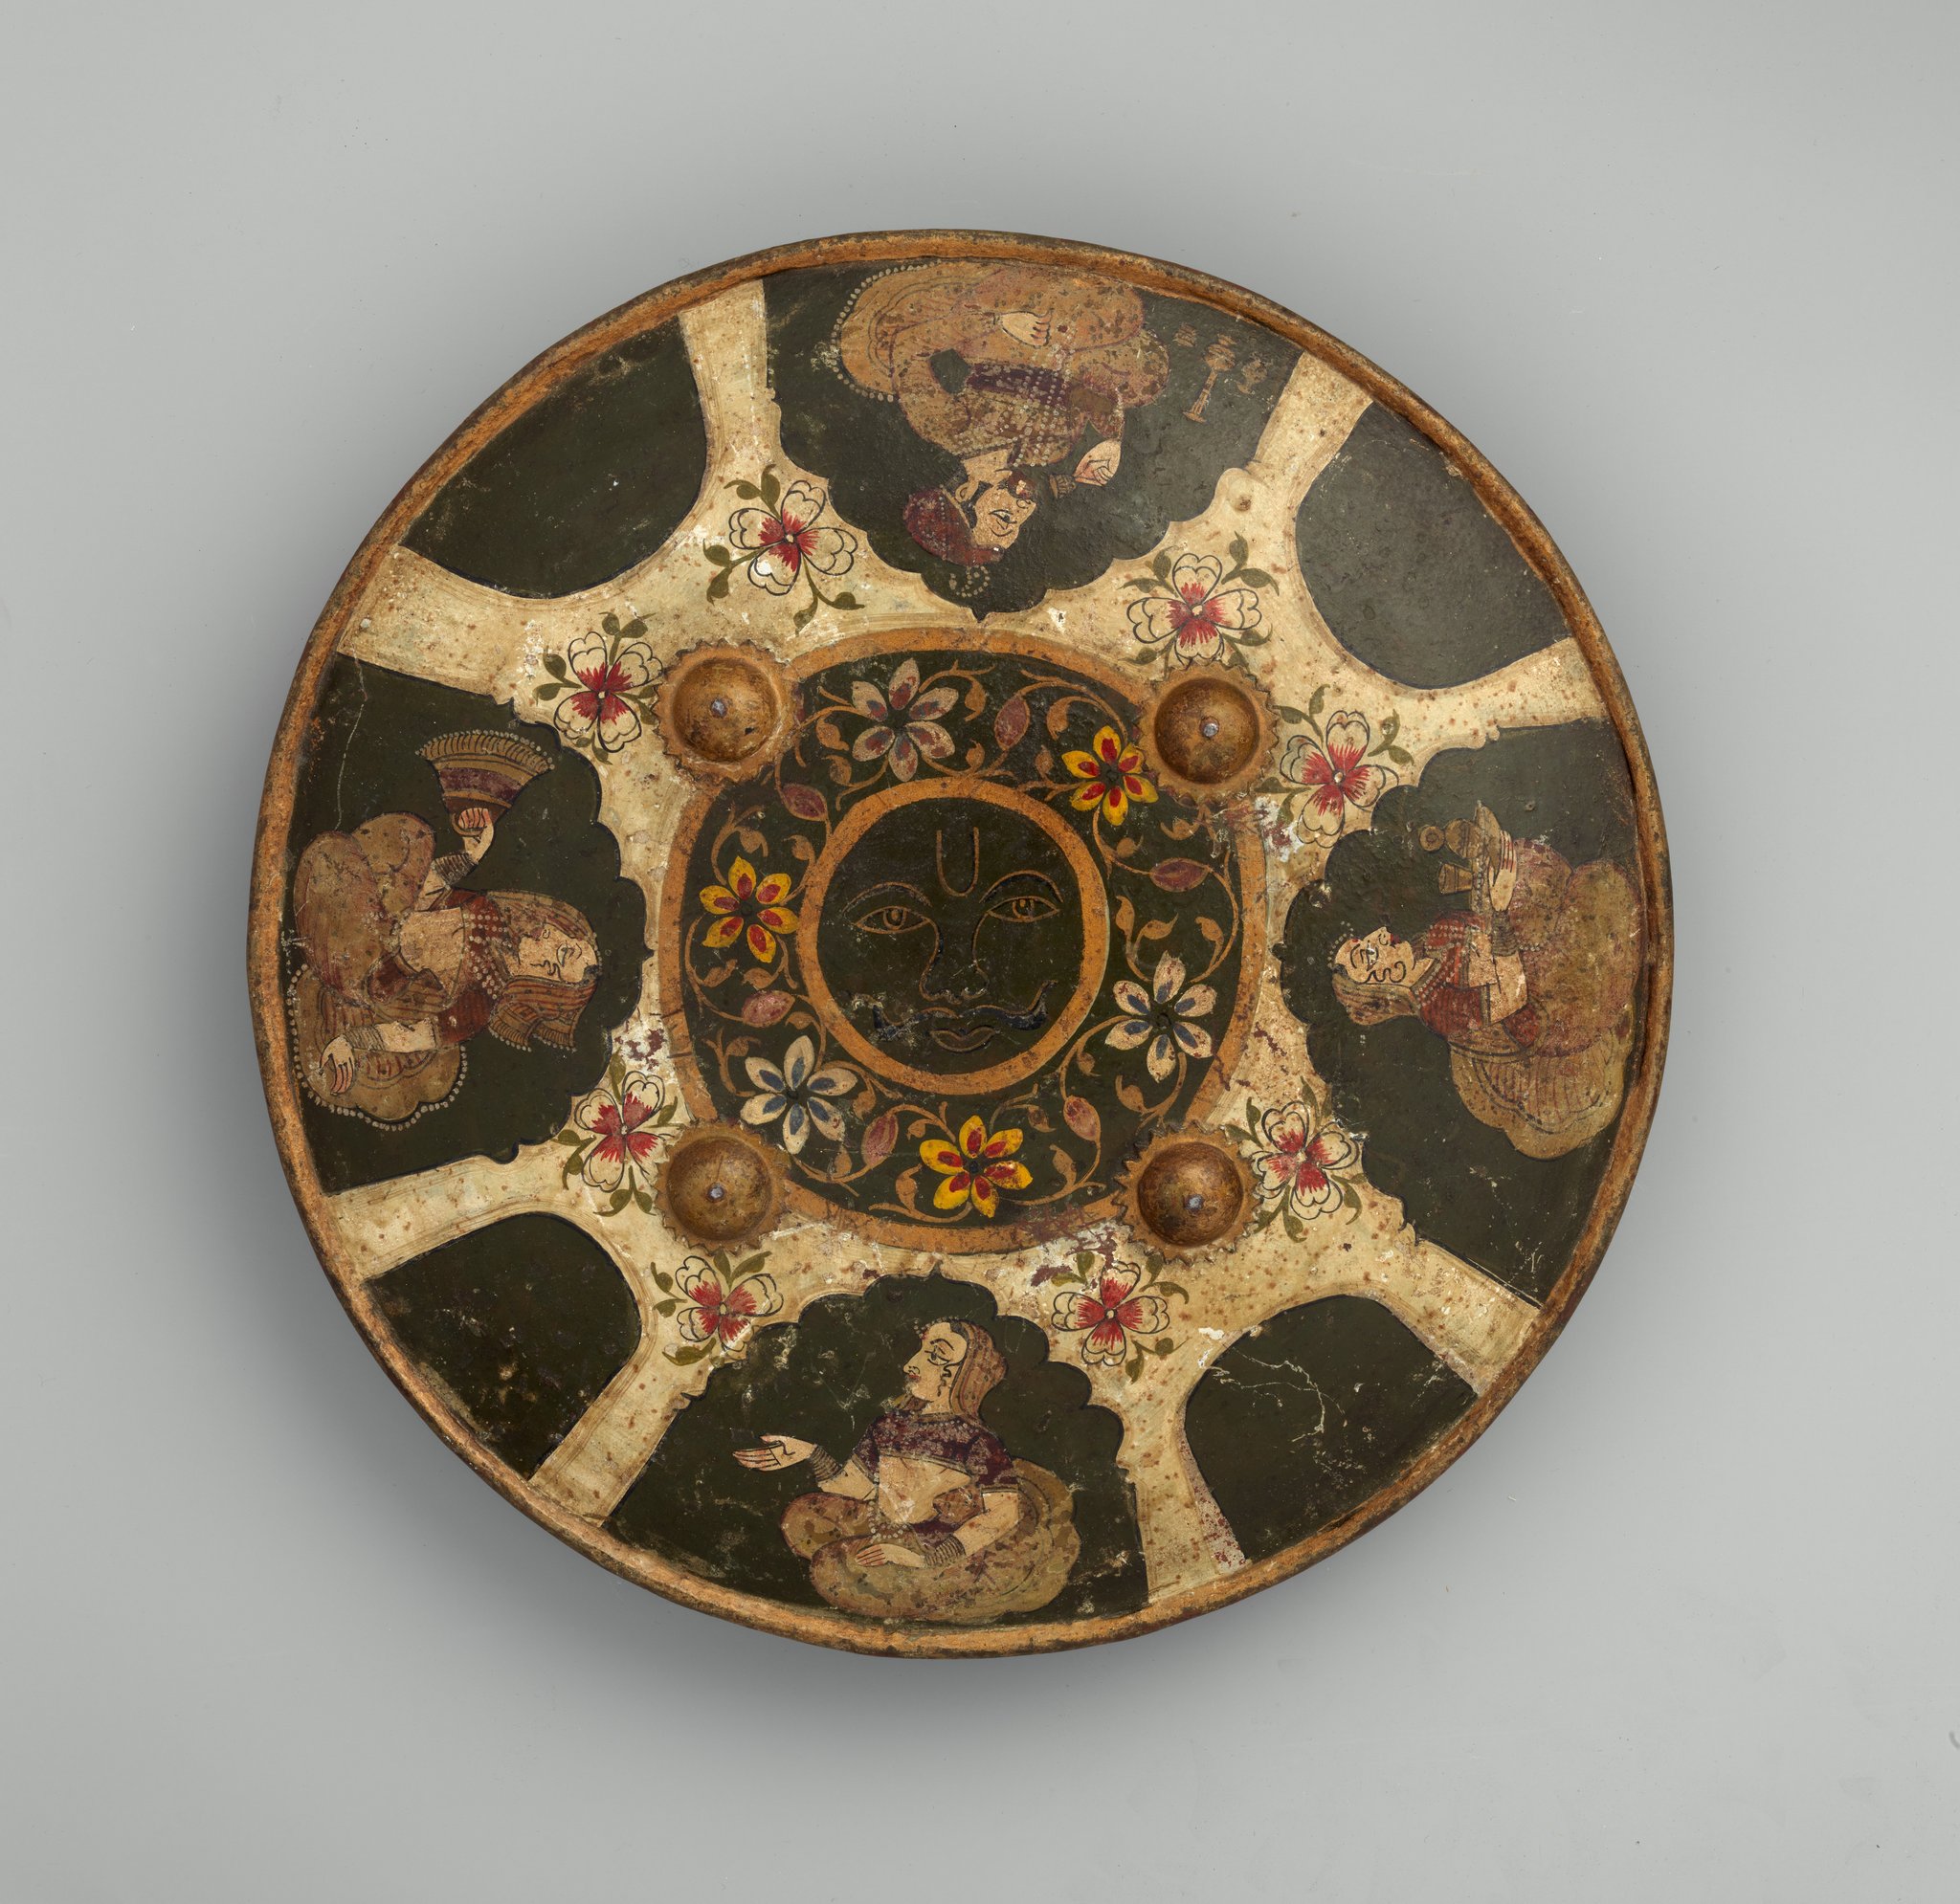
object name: shield dhàl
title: Shield (Dhál)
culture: indian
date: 1701-1833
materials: iron, leather, textile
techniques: polychromy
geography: india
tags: men,women